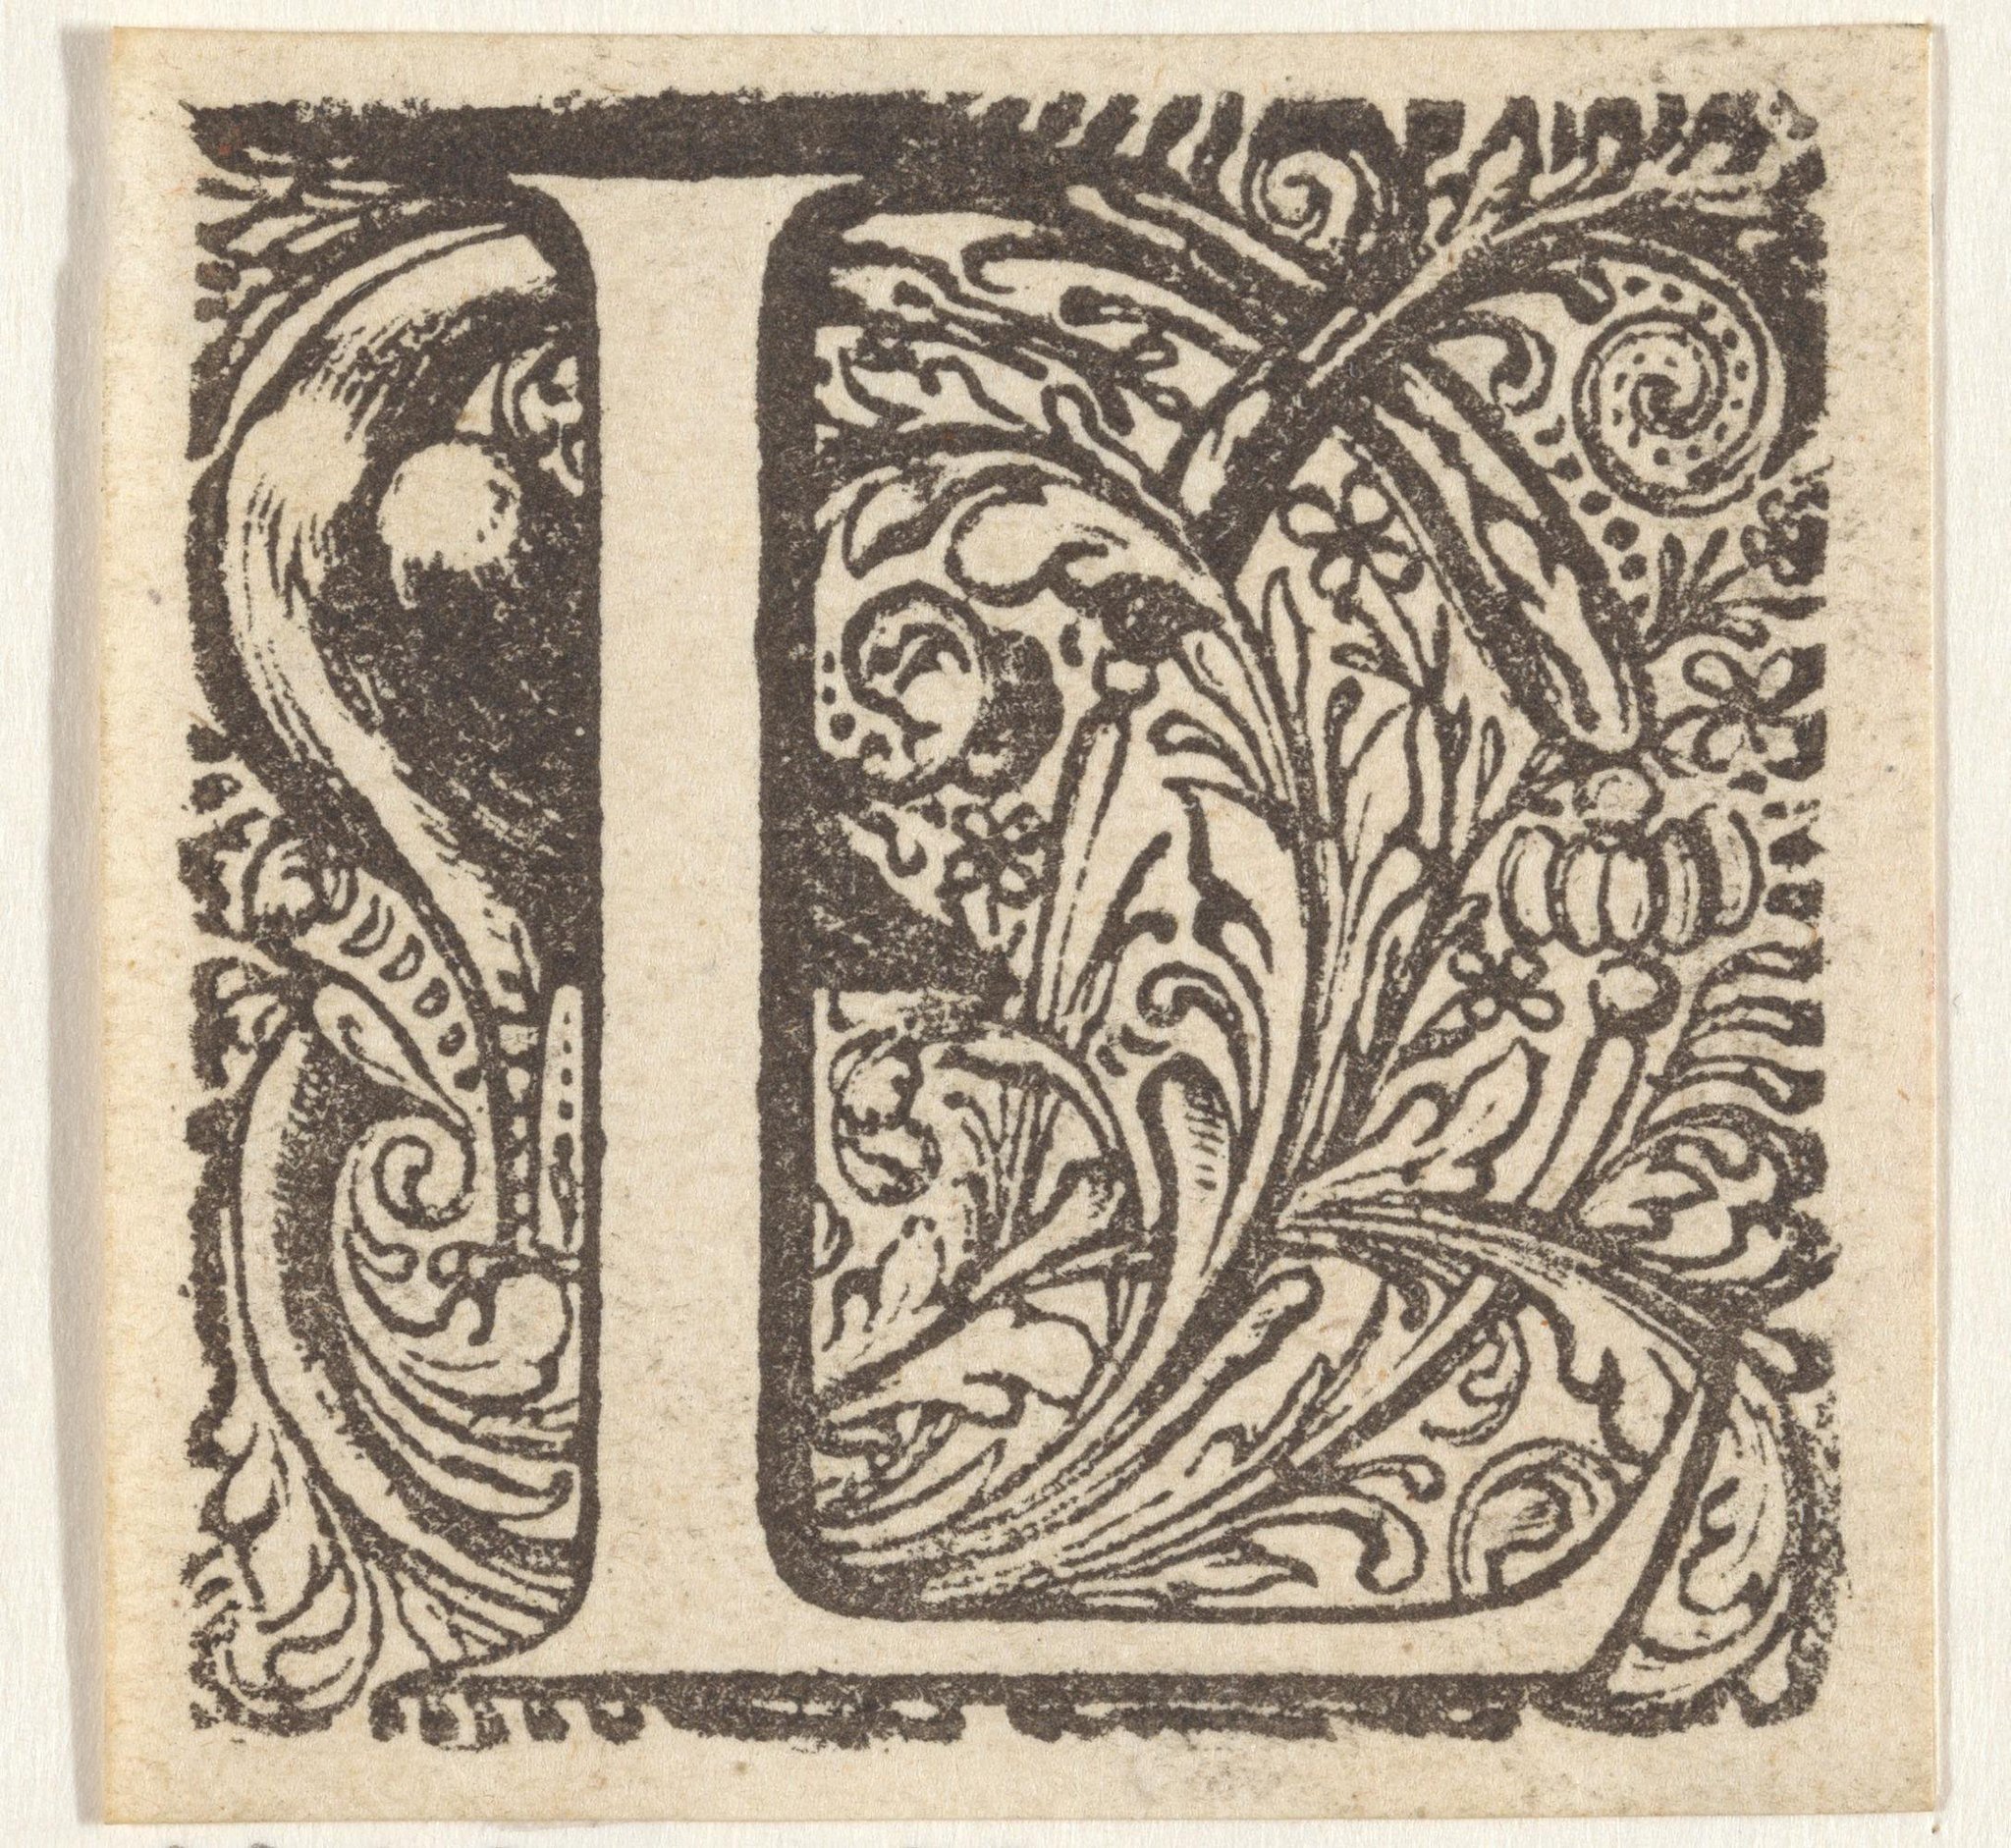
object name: print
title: Letter L in een omlijsting met een vogel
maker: Anonymous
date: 1600-1699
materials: paper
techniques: woodcut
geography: netherlands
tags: birds, fancy letters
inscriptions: collector's mark: Lugt 240